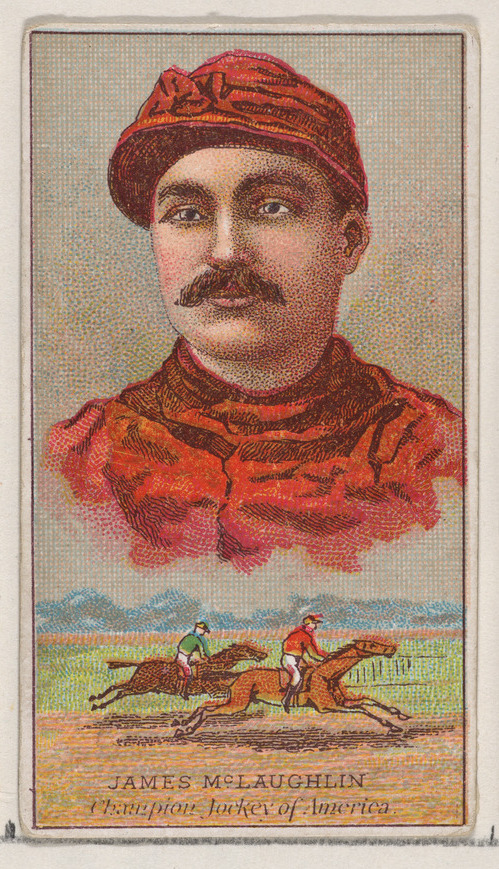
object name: print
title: James McLaughlin, Champion Jockey of America, from the Champions of Games and Sports series (N184, Type 2) issued by W.S. Kimball & Co.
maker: w.s. kimball & co.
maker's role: publisher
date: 1887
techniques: color lithograph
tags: men,horses,athletes,jockeys